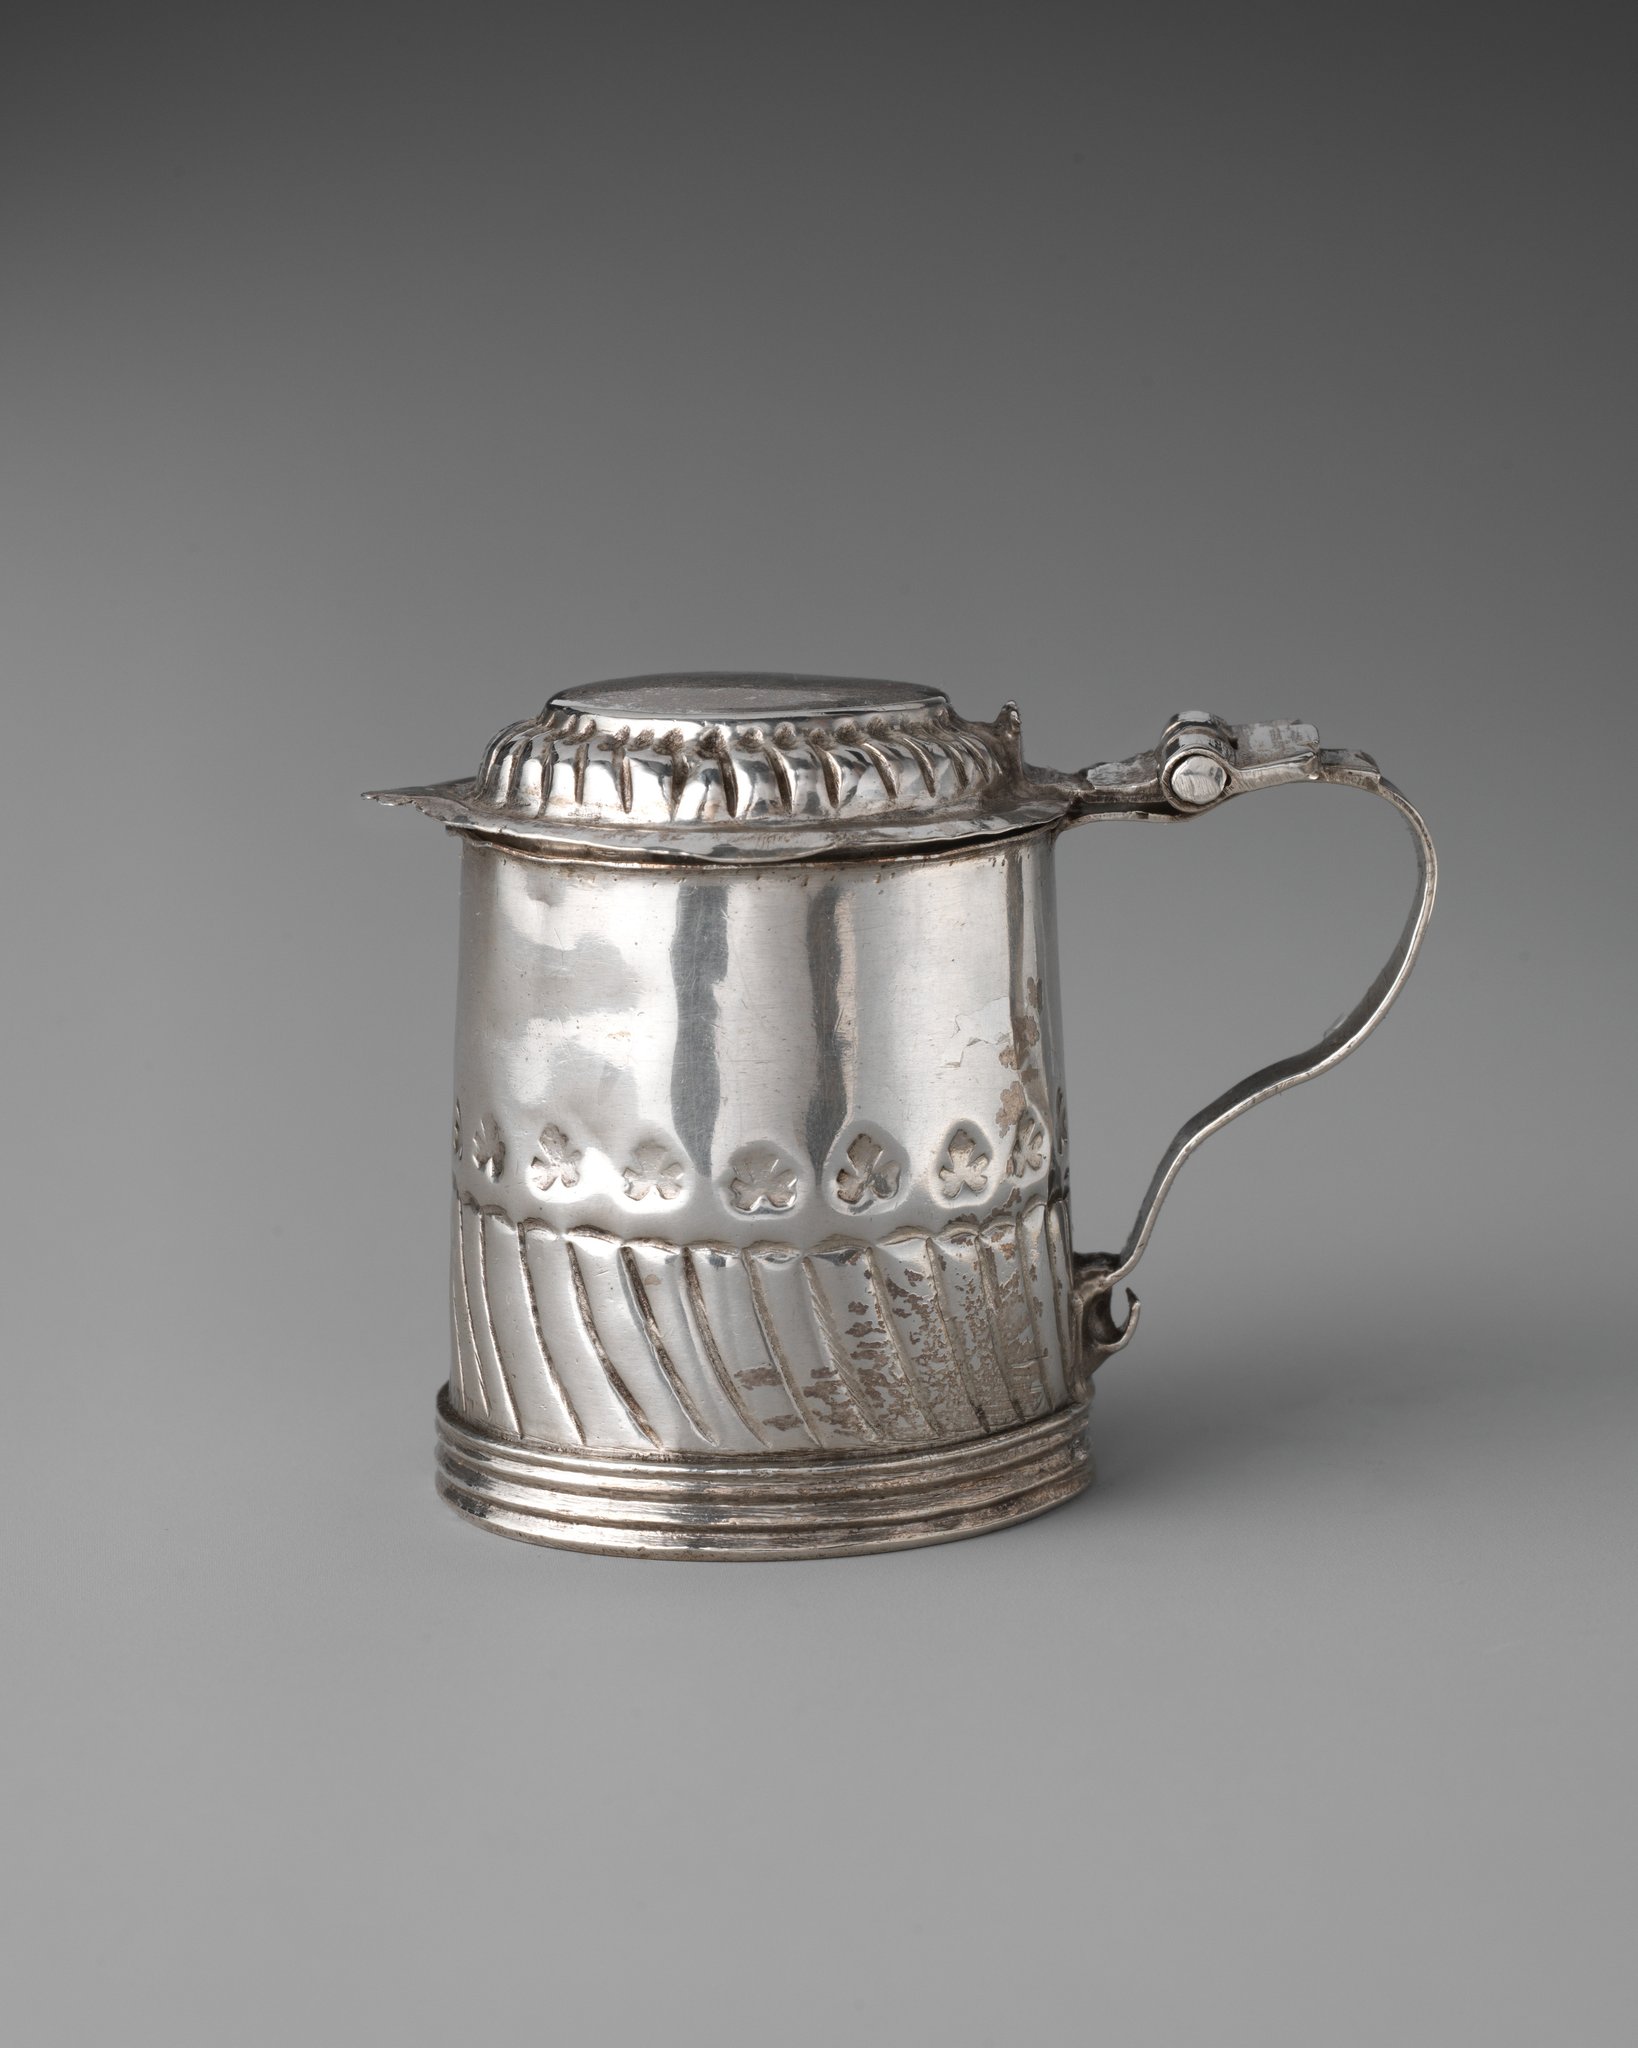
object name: tankard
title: Miniature tankard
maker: george manjoy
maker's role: maker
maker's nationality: british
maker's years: 1685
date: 1707-1708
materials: silver